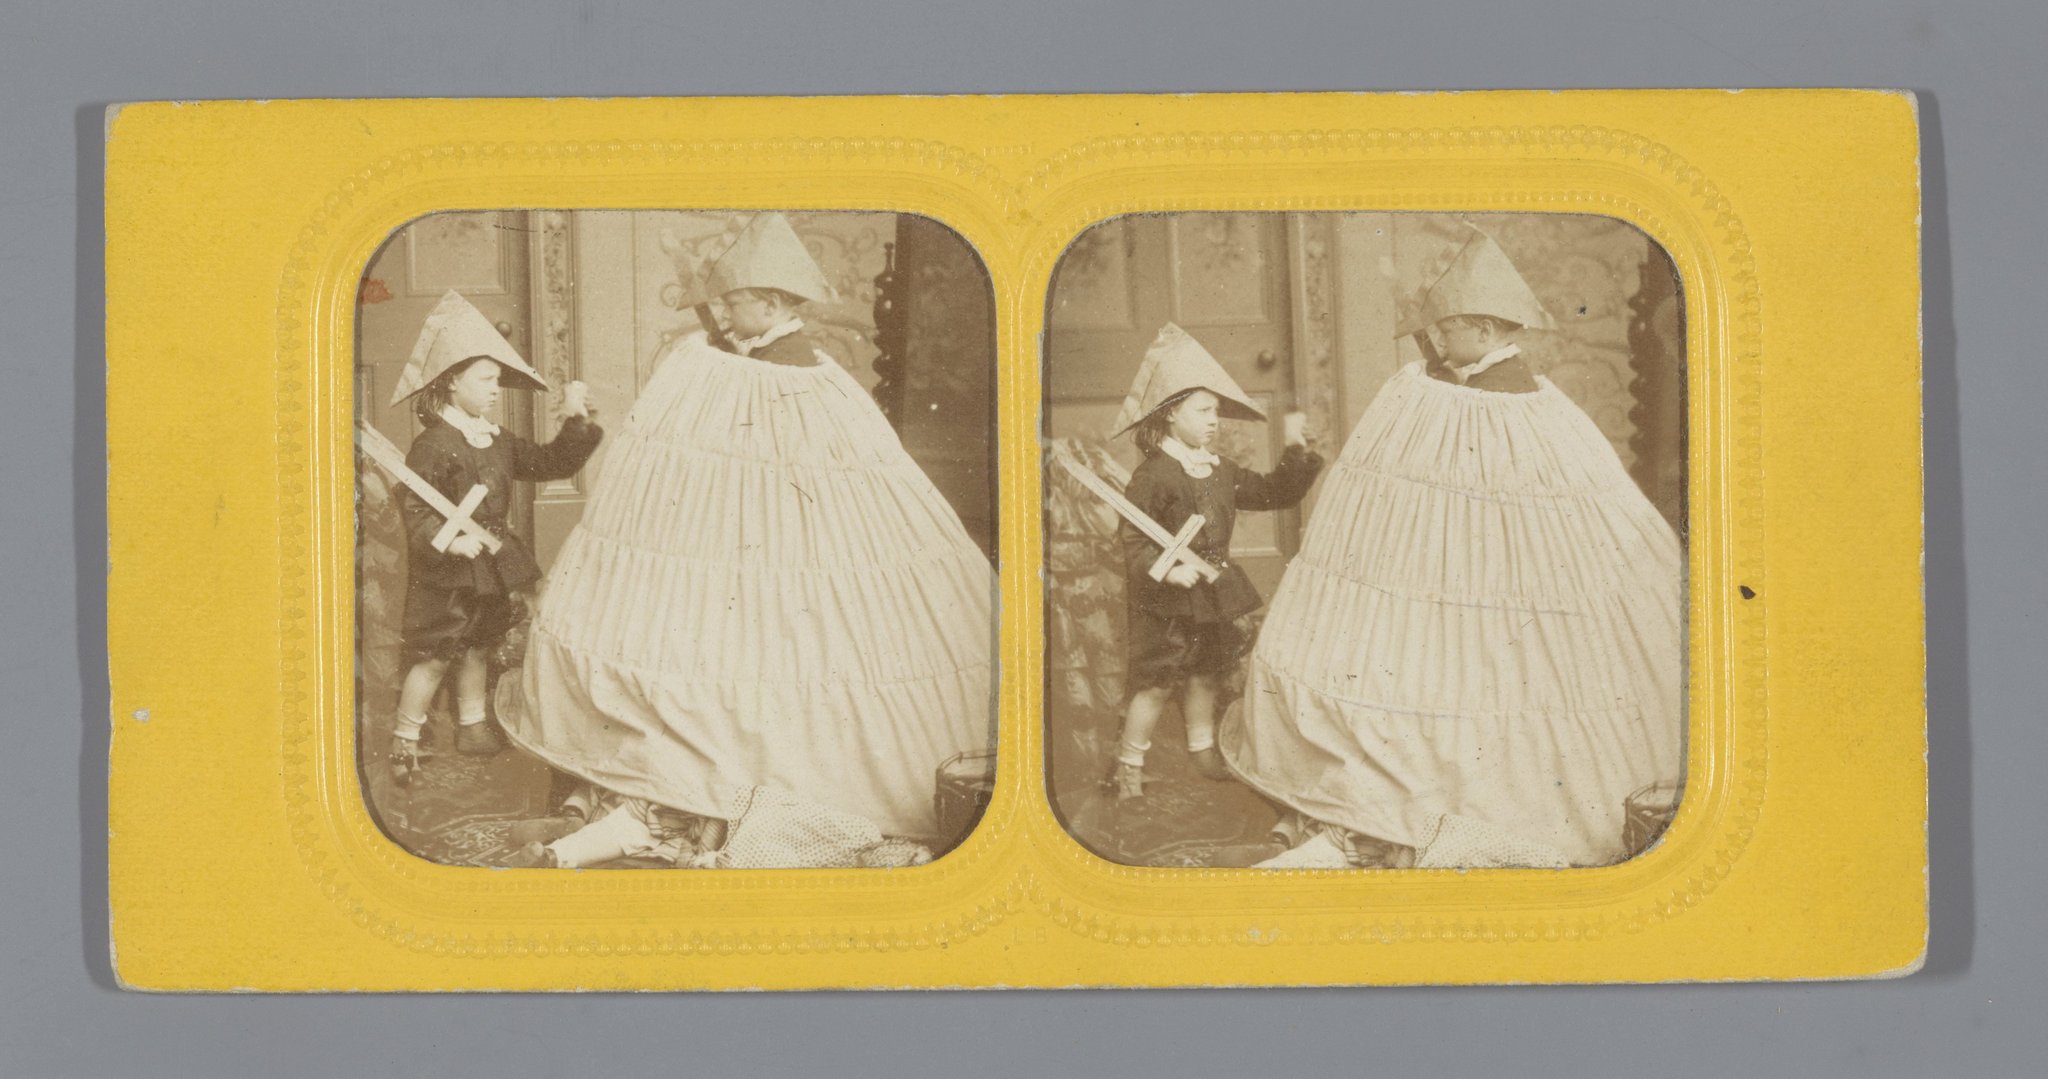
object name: tissue stereograph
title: Twee jongens spelen met crinolinerok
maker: l.b. (fotograaf)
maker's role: fotograaf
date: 1855-1875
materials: cardboard, paper, photographic support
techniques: albumen print, cutting, hand coloring, perforating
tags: other children's games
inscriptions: inscription: ‘D.3.’, inscription: ‘DEPOSÉ’